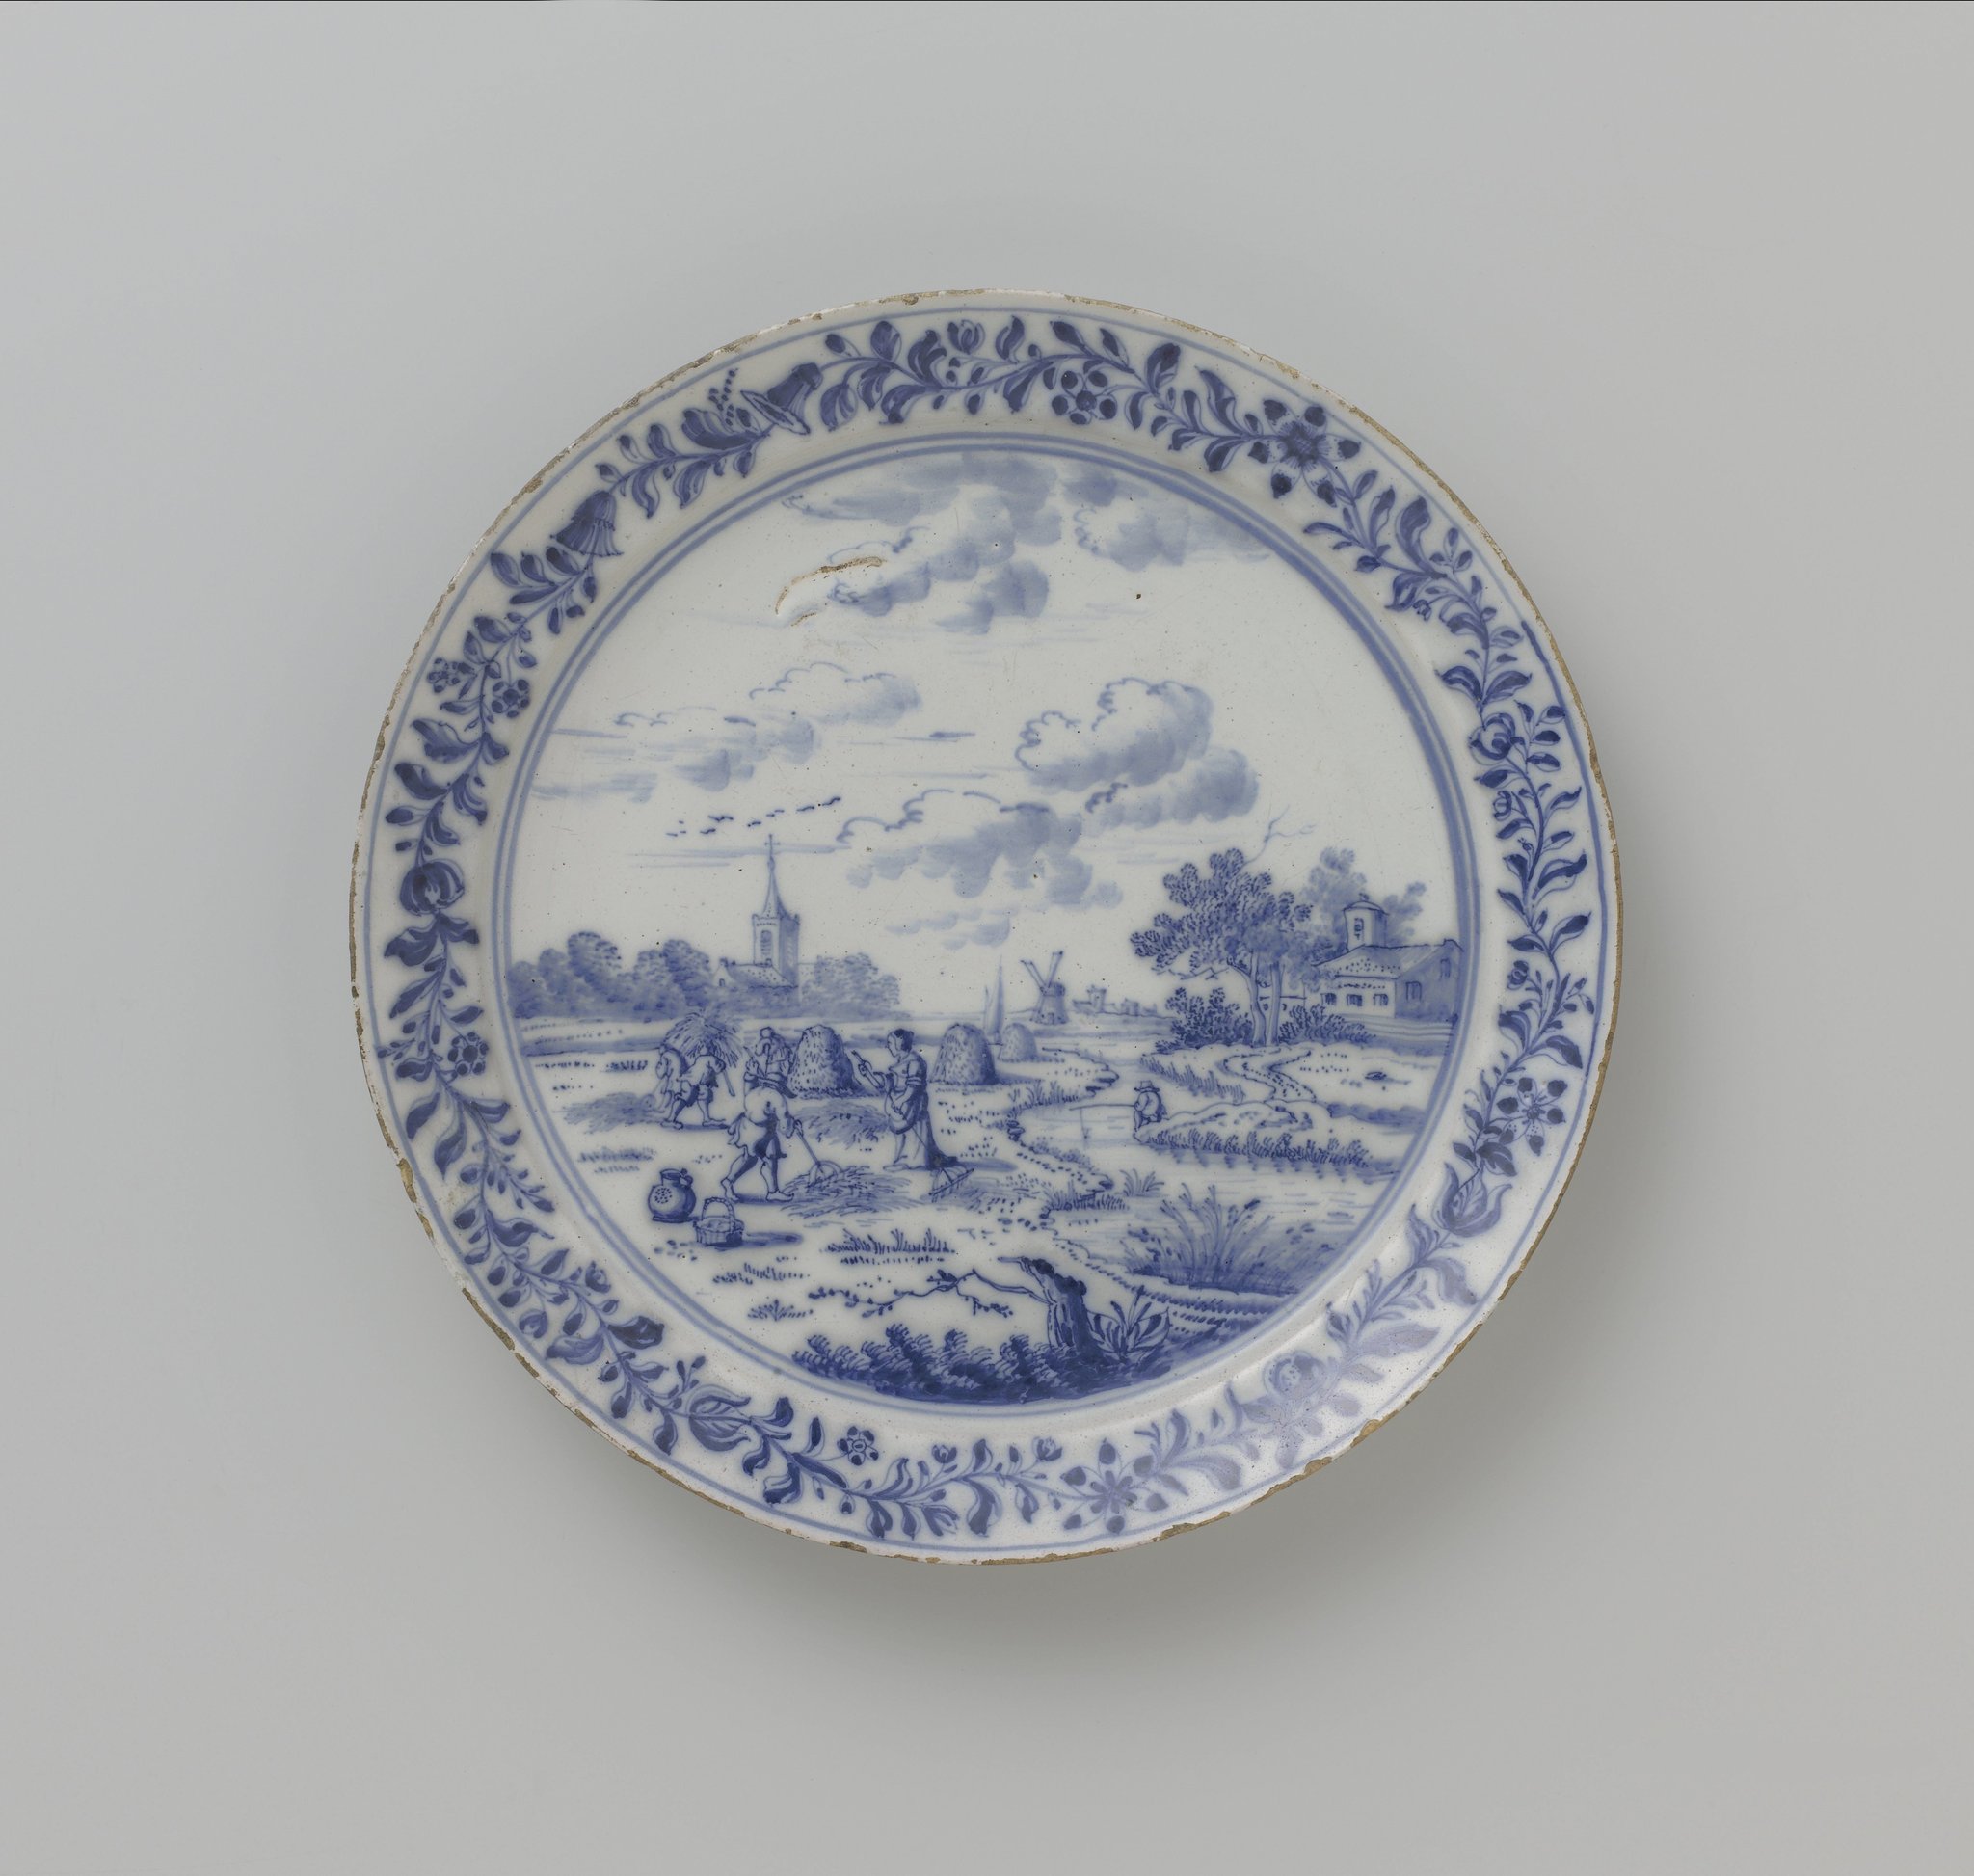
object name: plate dish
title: Plate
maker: Anonymous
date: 1710-1735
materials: faience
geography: amsterdam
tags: agricultural products and by-products: hay, landscapes in the temperate zone